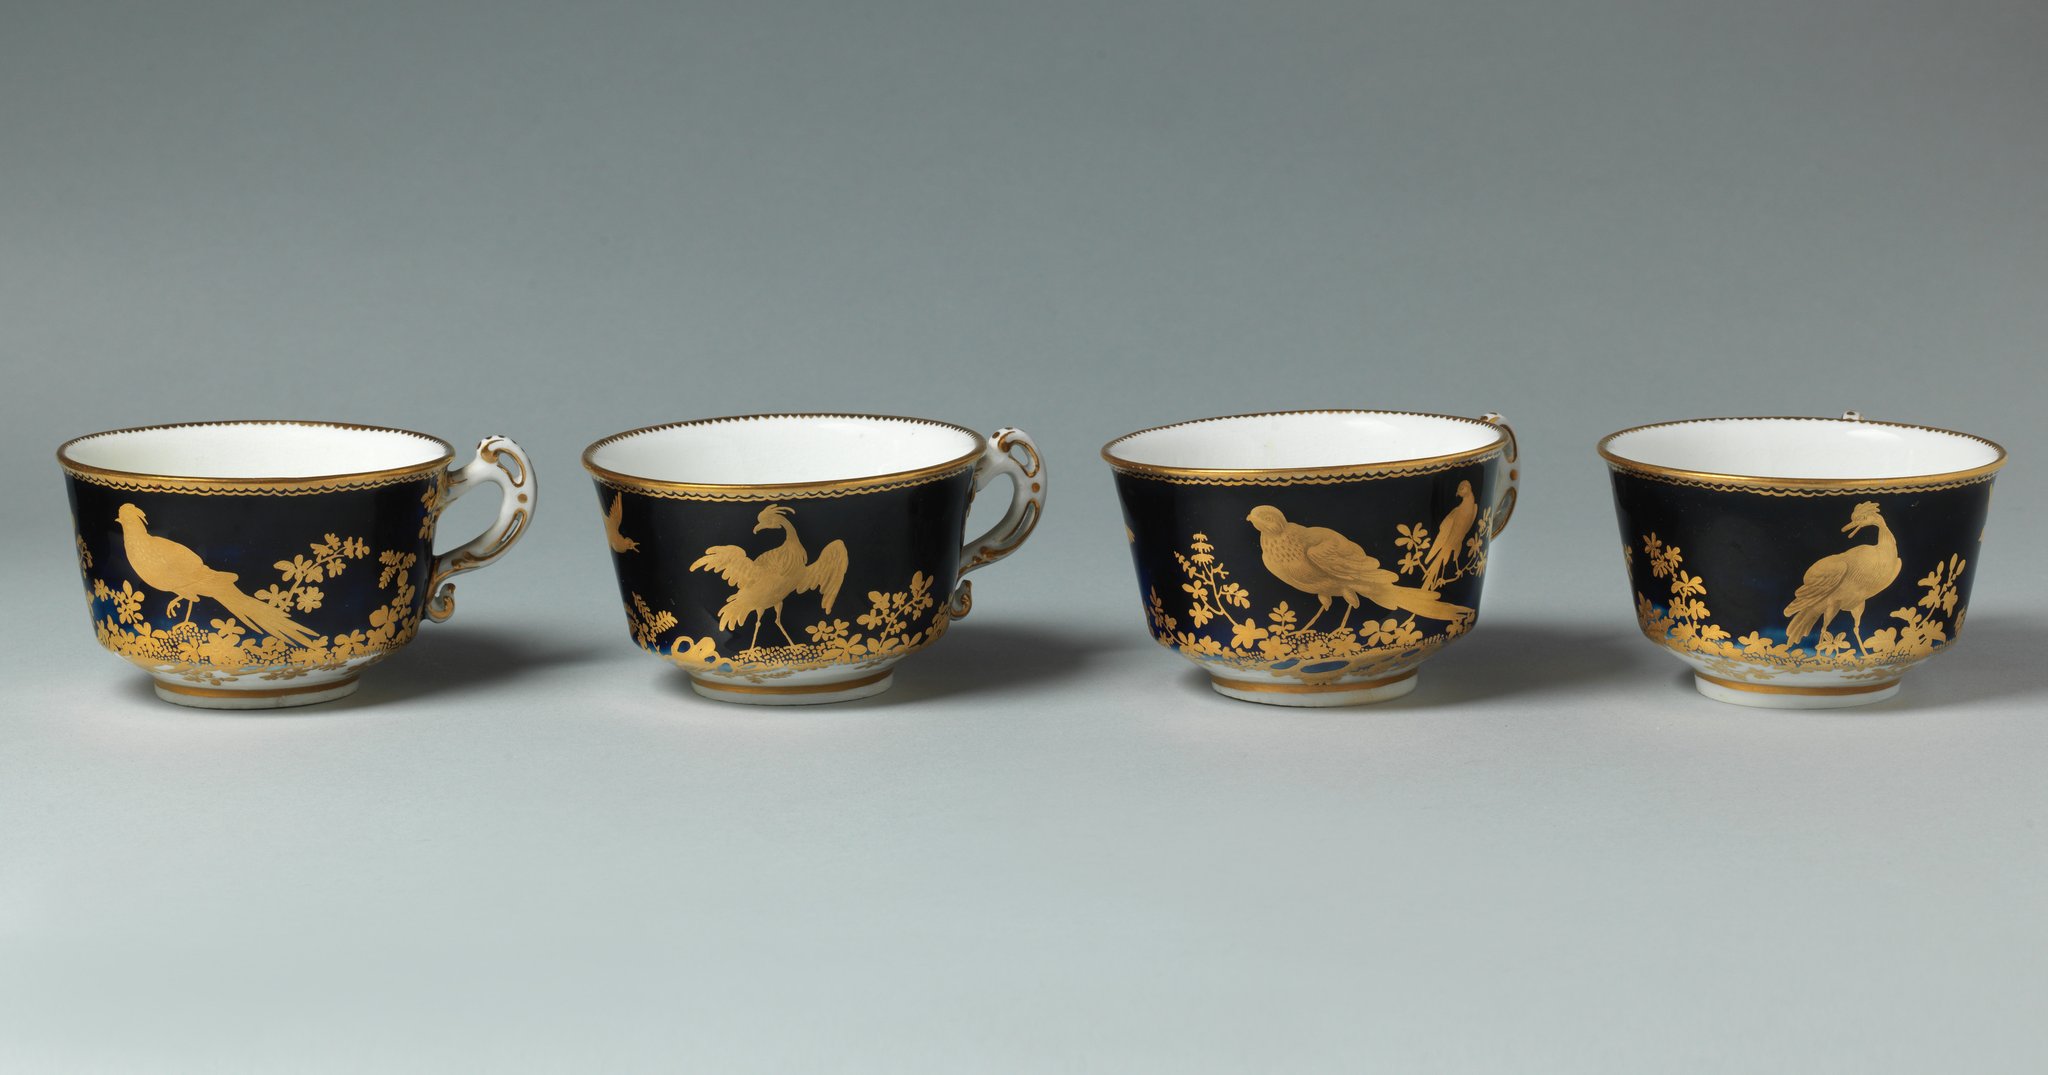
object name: teacup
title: Teacups (8) (part of a service)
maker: chelsea porcelain manufactory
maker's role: factory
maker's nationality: british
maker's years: 1744-1784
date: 1758-1769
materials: soft paste porcelain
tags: peacocks,pheasants